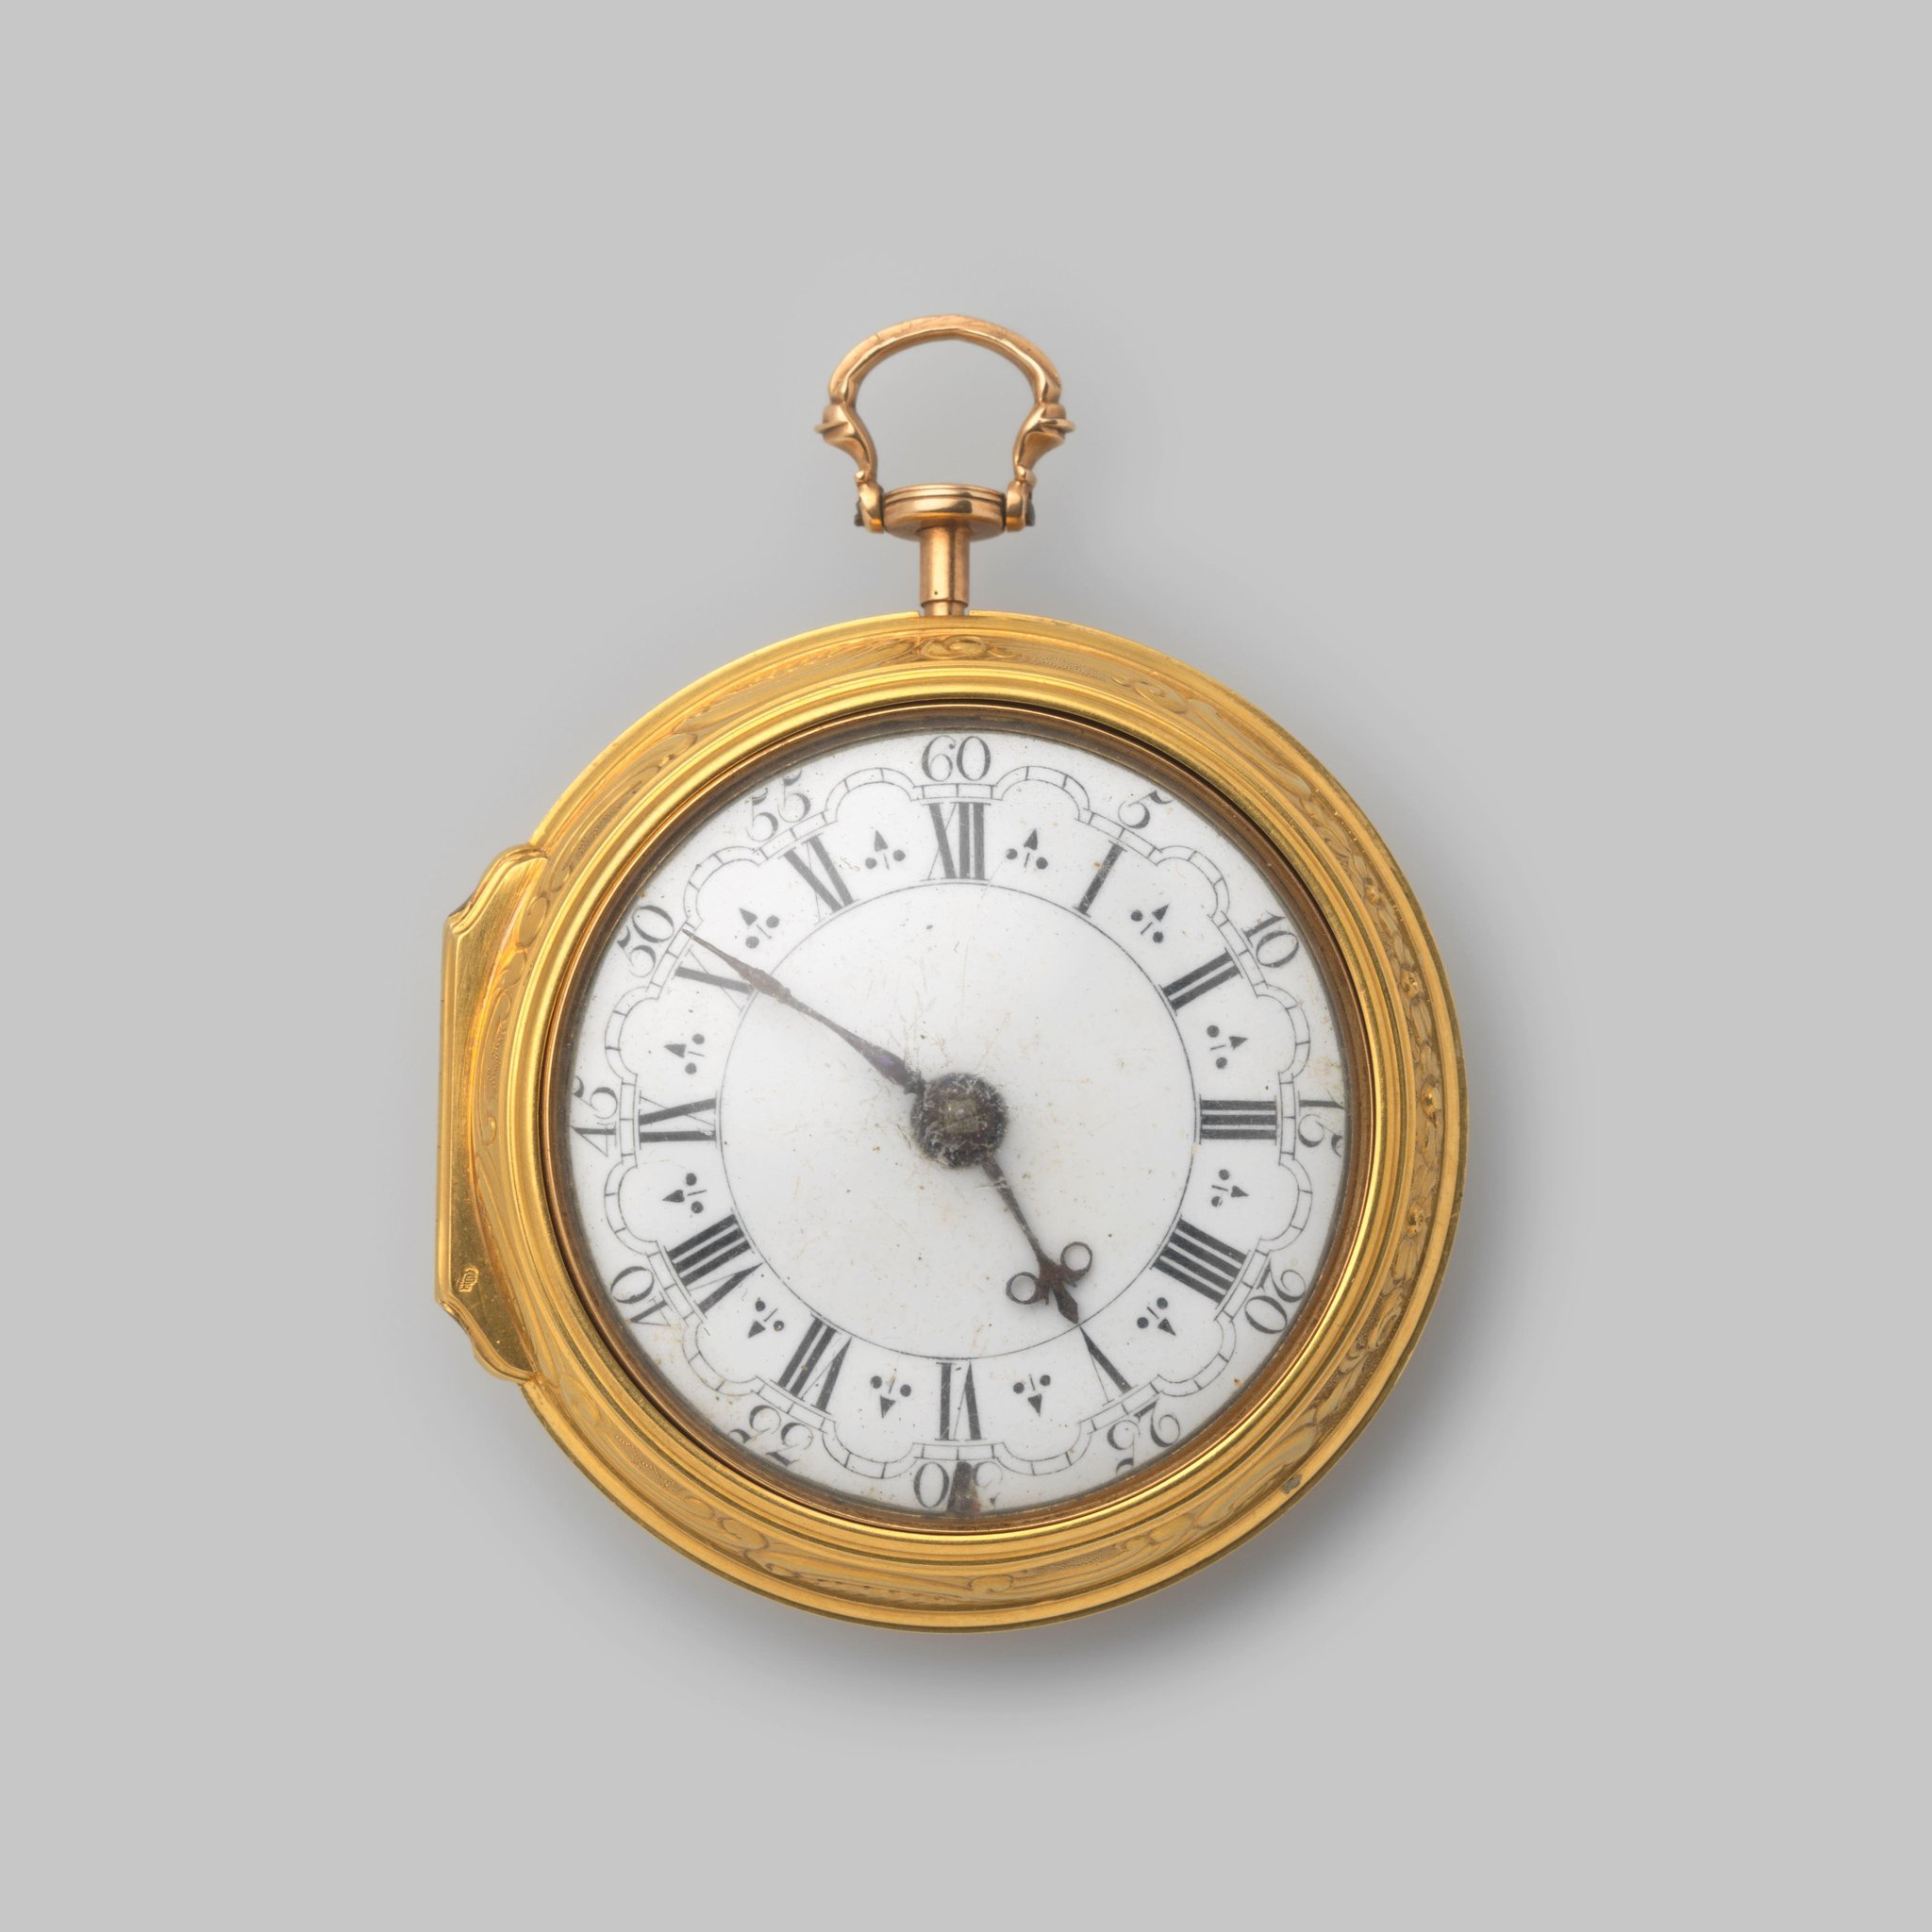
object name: jewellery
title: Horloge van goud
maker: rayment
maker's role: clockmaker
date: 1769-1770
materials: gold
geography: london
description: Gouden horloge met geëmailleerde wijzerplaat. In de buitenkast is een voorstelling gedreven van een krijgsman met een vrouw.